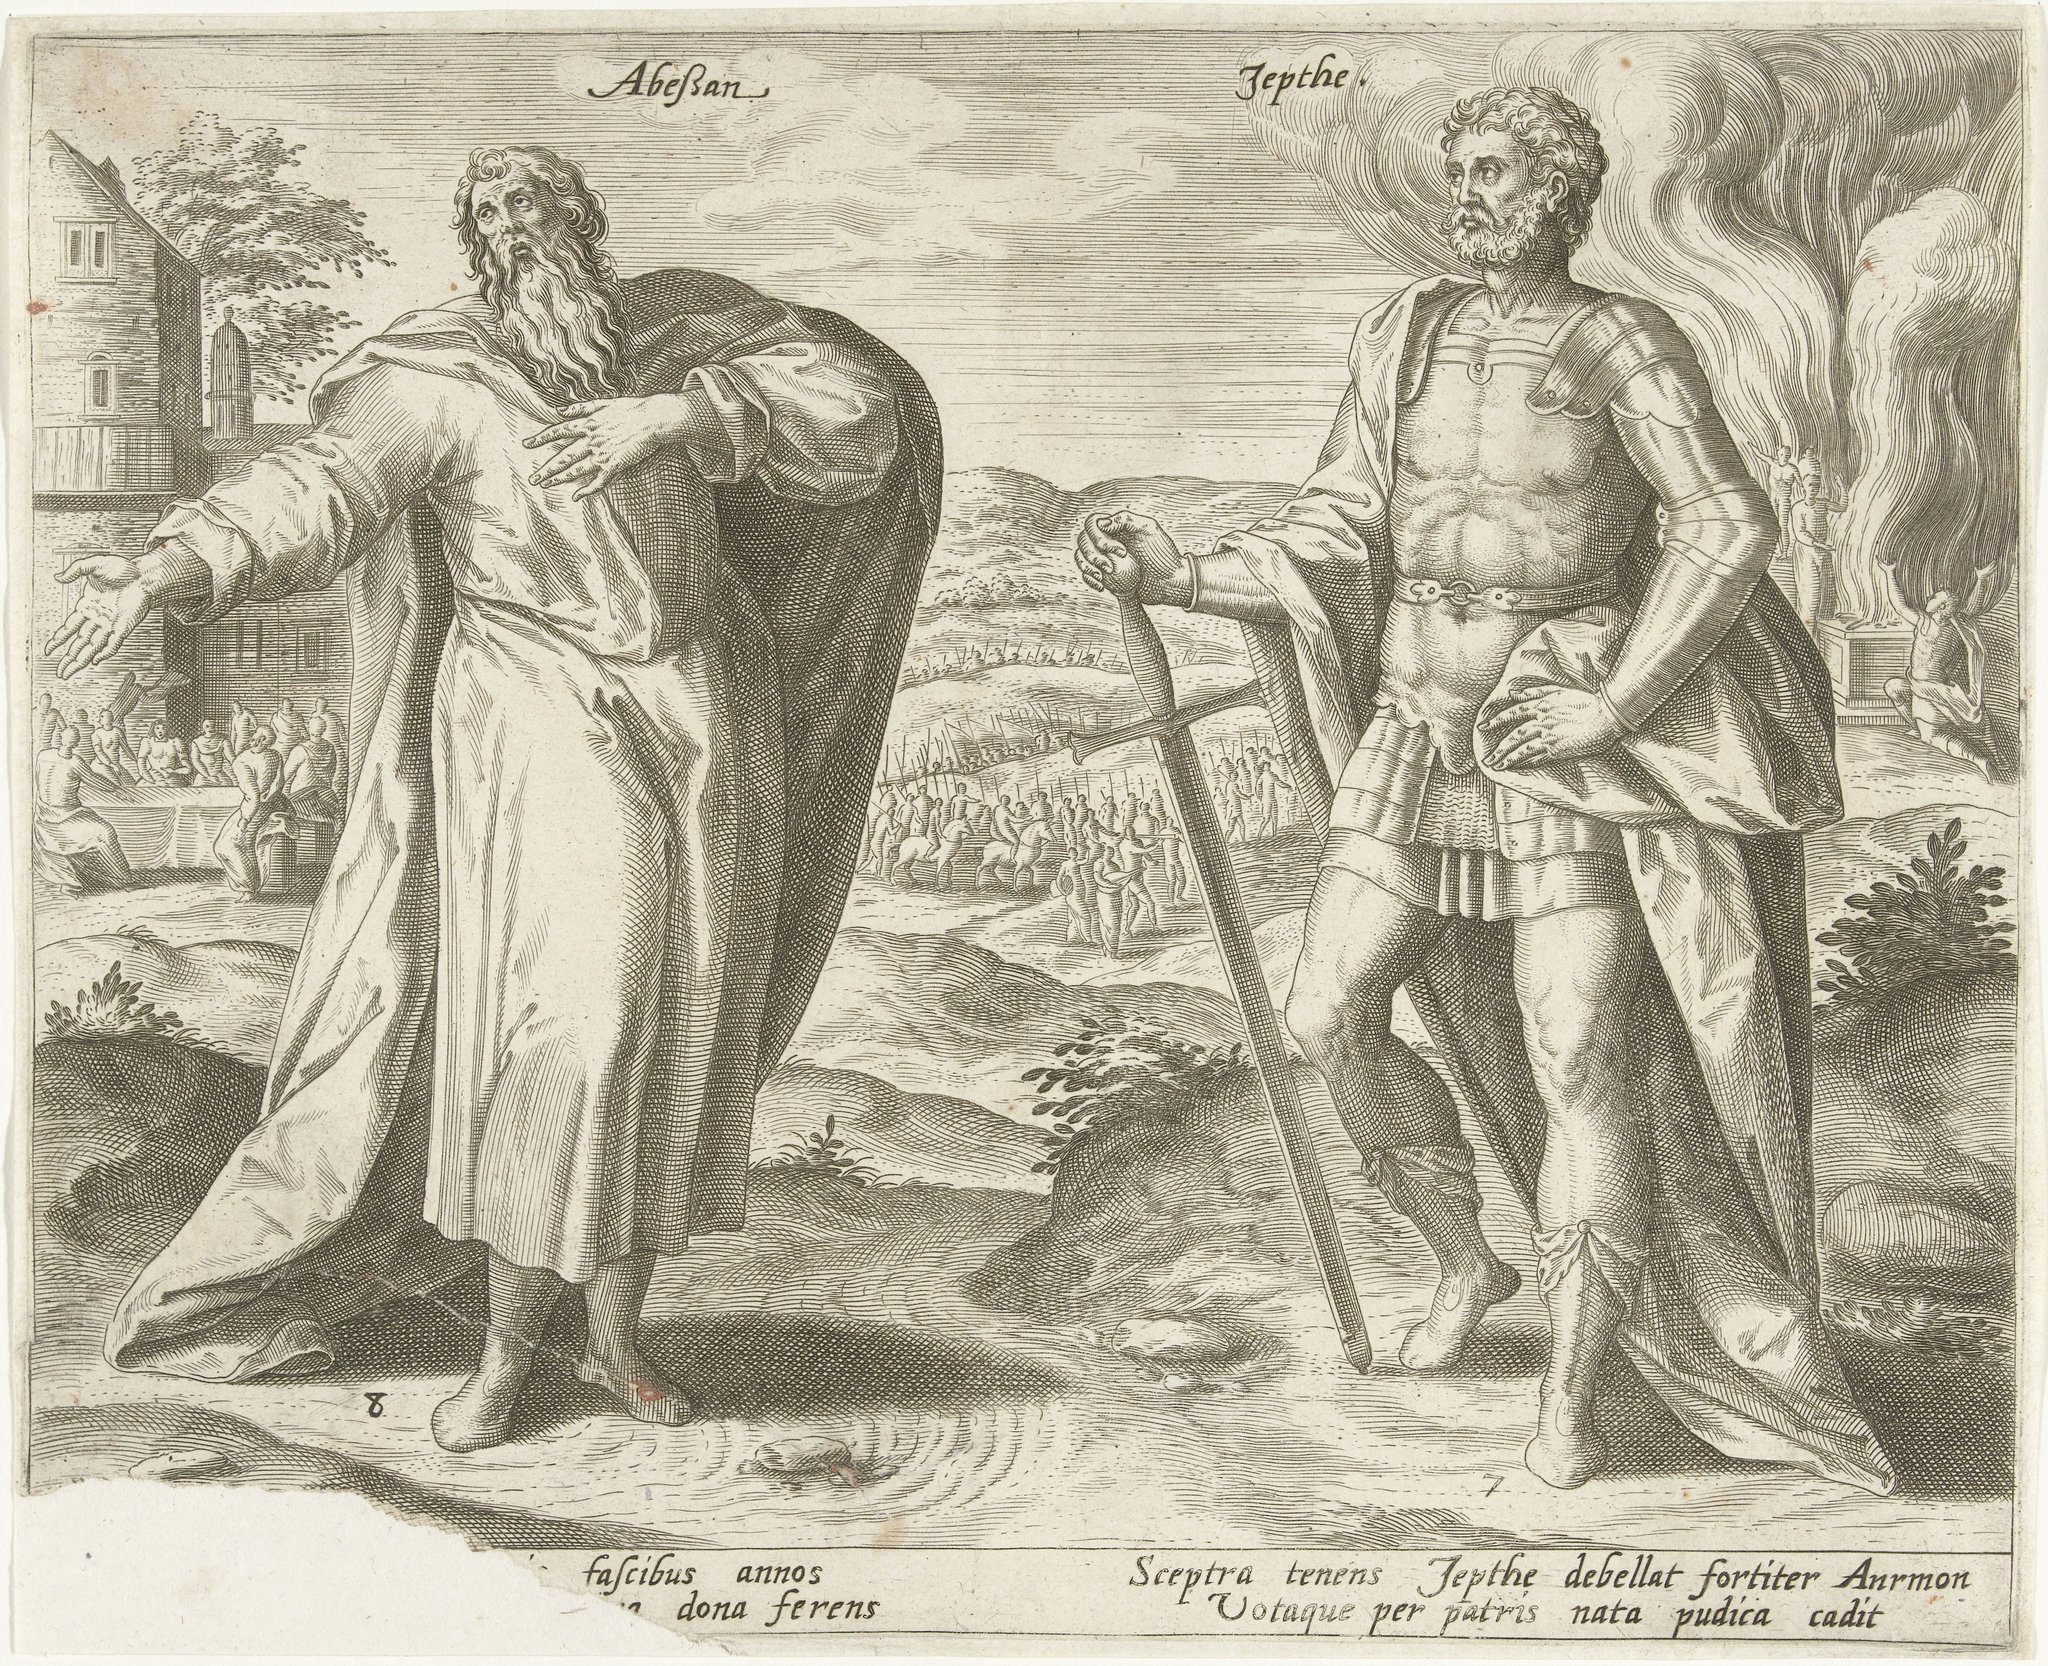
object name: print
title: Ibsan en Jefta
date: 1585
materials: paper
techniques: engraving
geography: antwerp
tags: fulfilment of jephthah's vow to the lord: jephthah's daughter is sacrificed, the time of ibzan (judges 12:8-10), male persons from the old testament (with name) (not in biblical context)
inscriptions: collector's mark: Lugt 2228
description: Op de voorgrond de zevende en achtste Rechter van Israel: Ibsan en Jefta. Op de achtergrond twee verhalen uit hun tijd. Rechts offert Jefta zijn eigen dochter aan God. Links de bruiloft van de dertig zonen van Ibsan. De prent heeft een Latijns onderschrift.